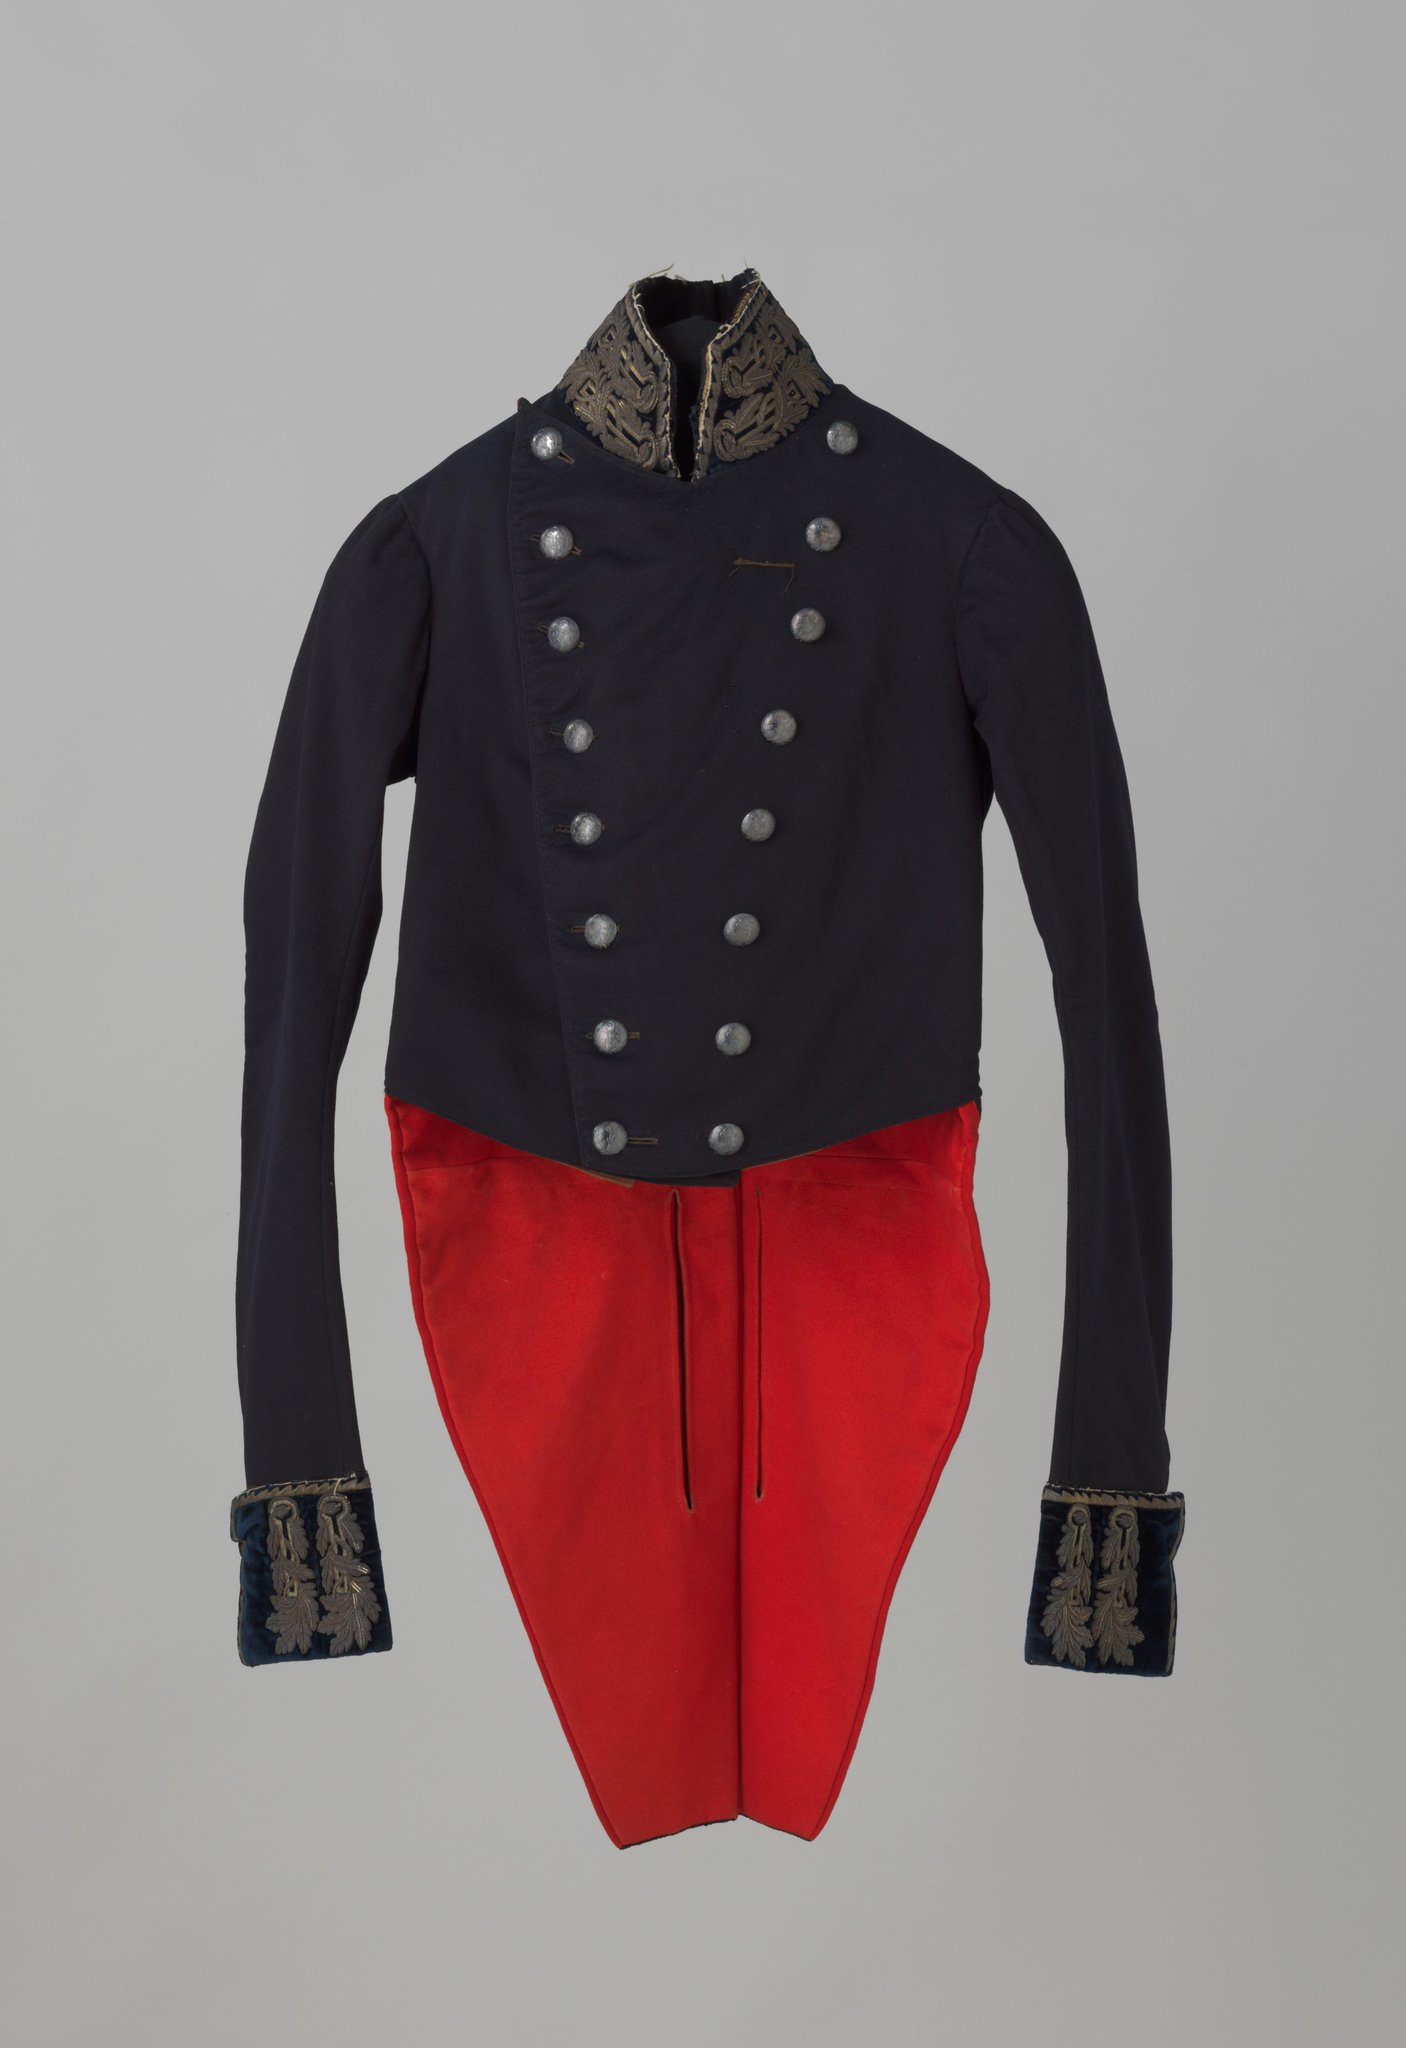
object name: wapenrok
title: Wapenrok van H. Pek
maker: Anonymous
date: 1820-1850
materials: textile, gold thread, leather, silver, velvet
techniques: embroidered, sewing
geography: amsterdam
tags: h. pek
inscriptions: inscription: ‘Amsterdam’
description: Een wapenrok van blauw laken met fluwelen kraag en opslagen met zilver geborduurd. Zilveren knopen met vesting en opschrift. Panden met witte biezen. Rok is van H. Pek, officier van gezondheid 2e en 3e klasse schutterij 1830.